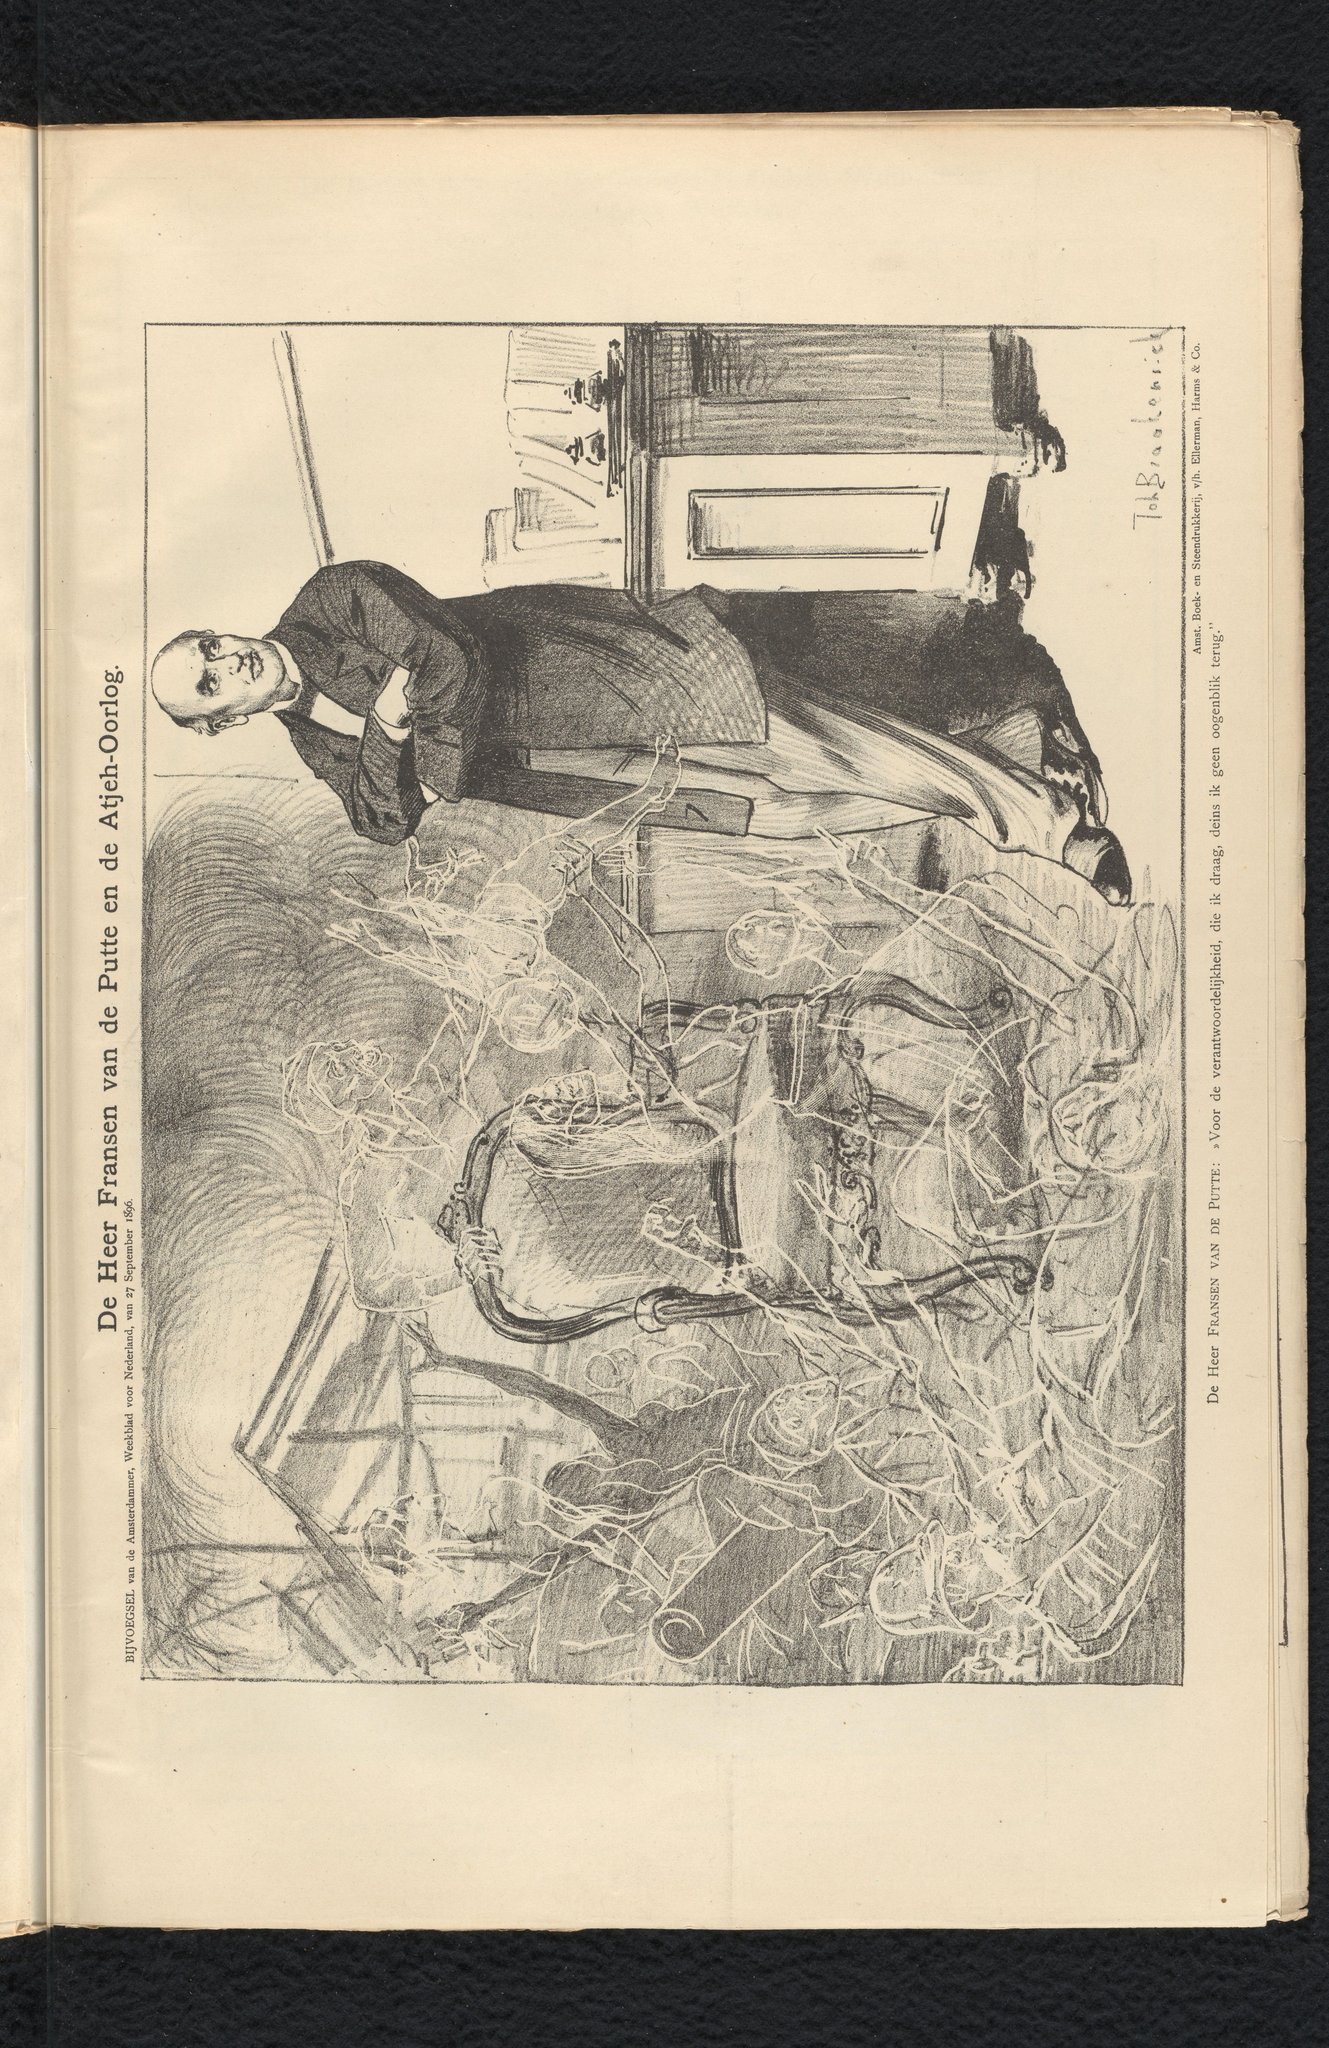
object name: cartoon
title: De Heer Fransen van de Putte en de Atjeh-Oorlog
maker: johan braakensiek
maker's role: draughtsman, print maker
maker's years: 1858-1940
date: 1896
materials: paper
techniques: lithograph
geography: amsterdam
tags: the hague, politician, minister ~ government, non-combatants ~ war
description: Isaäc Dignus Fransen van de Putte, voormalig minister van Koloniën, staande naast een lege stoel, kijkt weg van de schimmen van de Atjeh-oorlog die hem met uitgestrekte armen smeken om hulp.